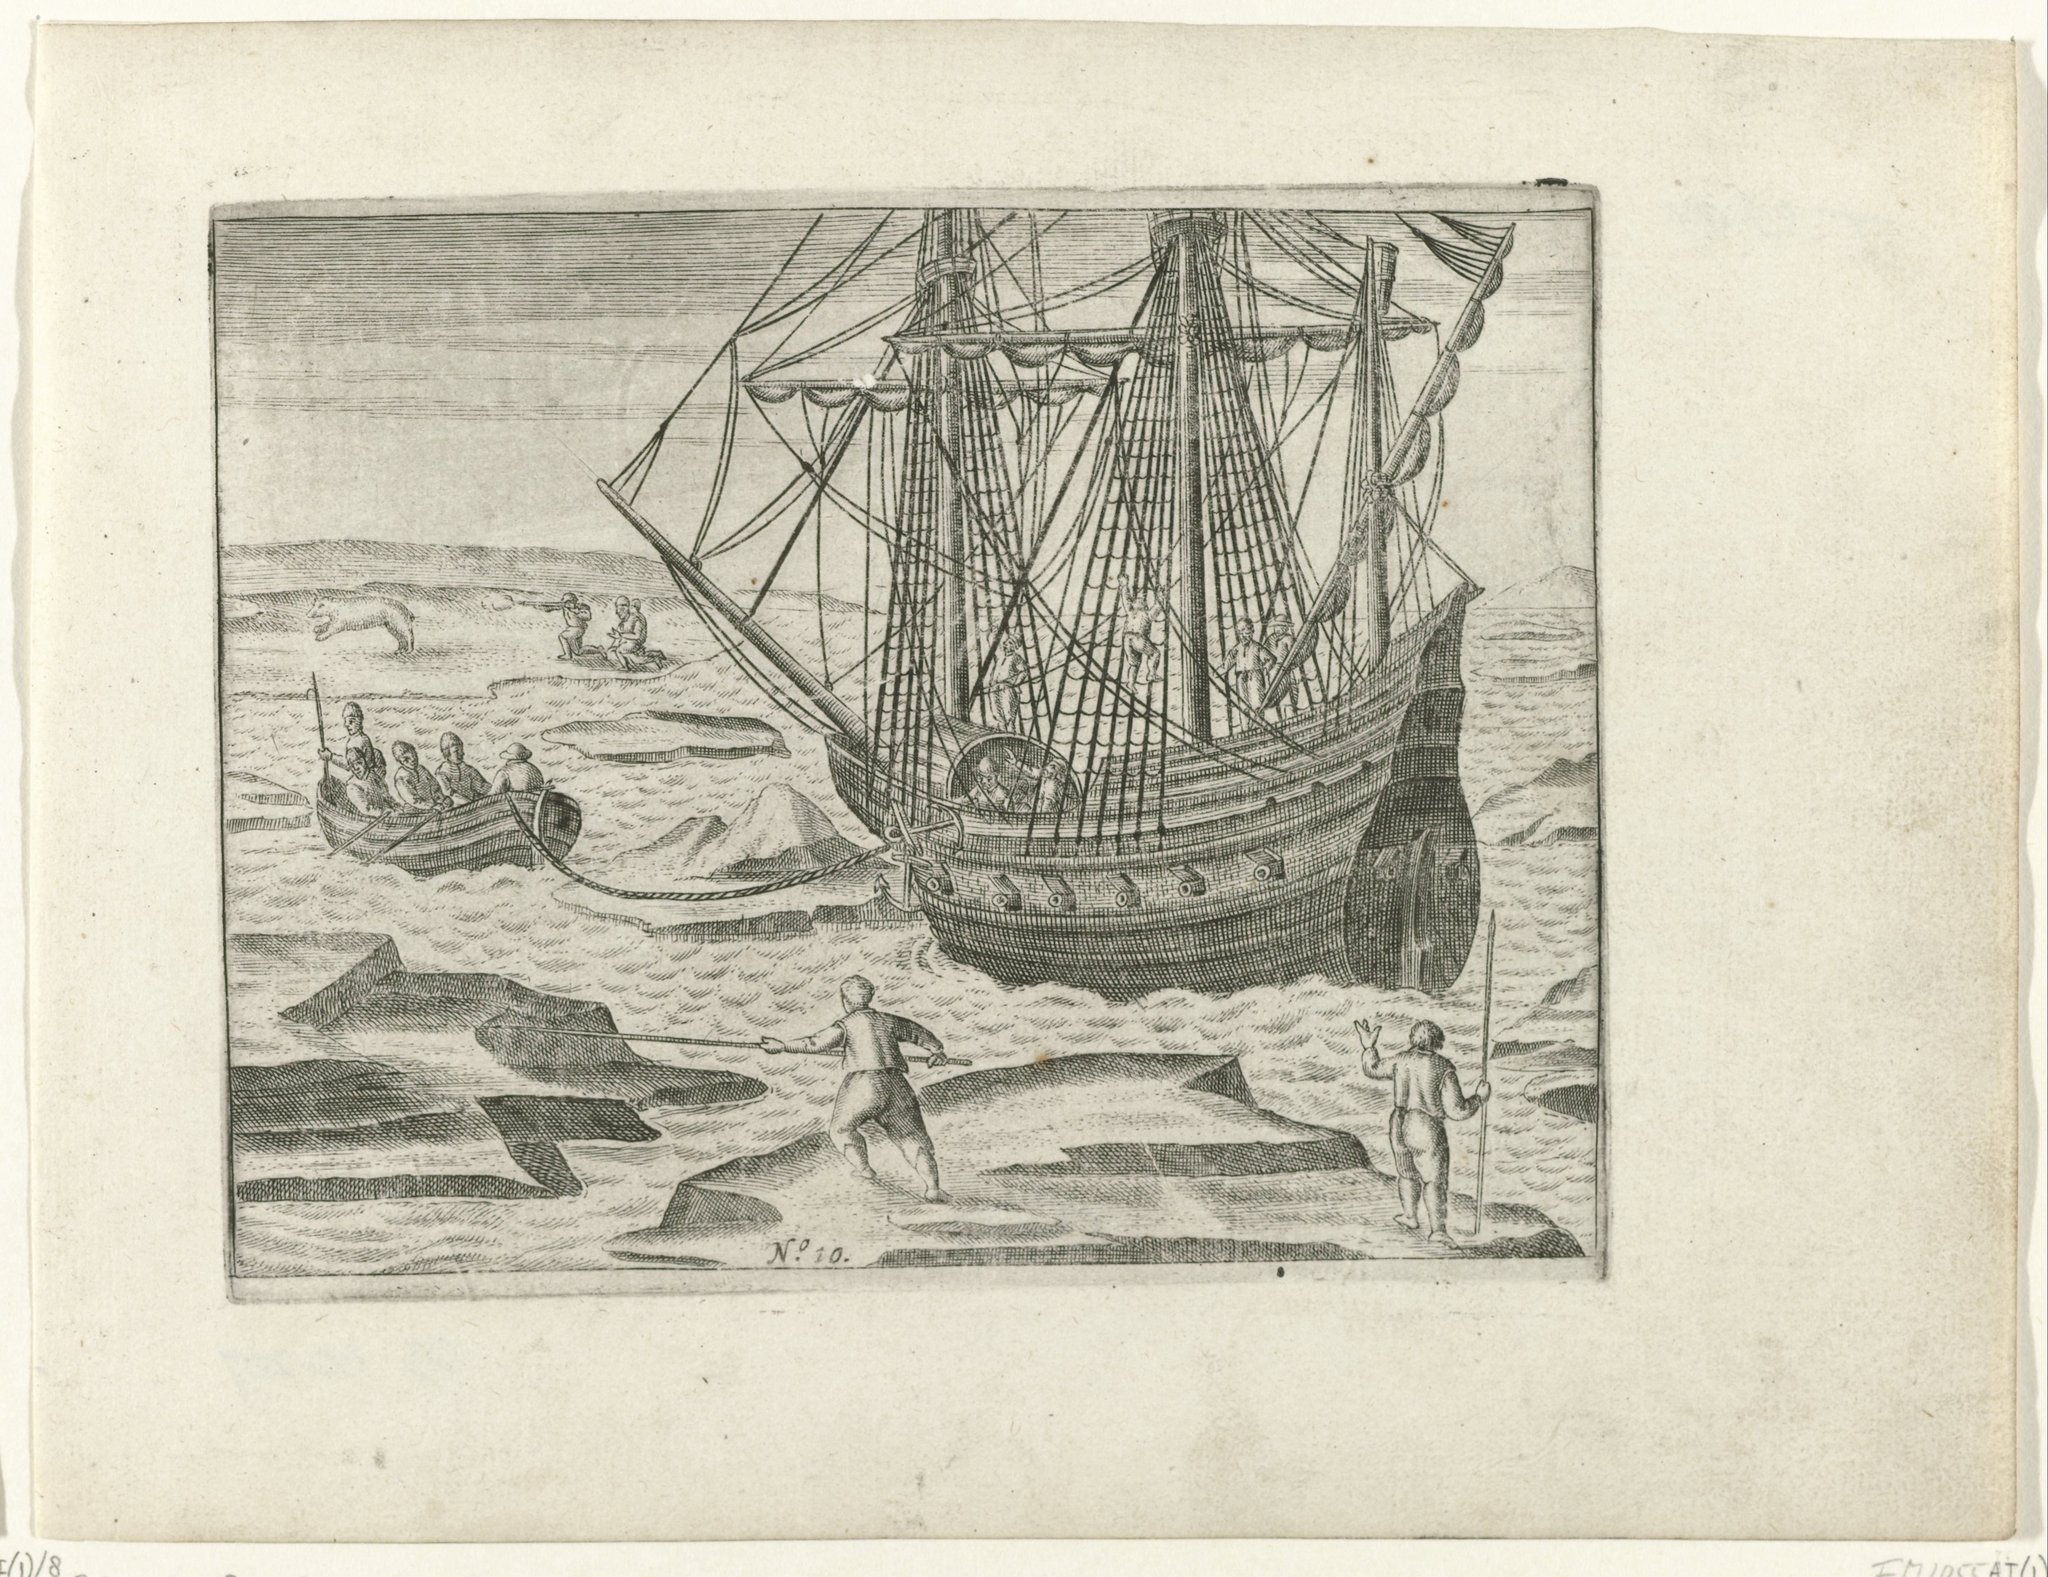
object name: history print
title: Het schip dreigt bij Oranje-eiland in het ijs vast te raken, 1596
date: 1615-1617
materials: paper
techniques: engraving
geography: northern netherlands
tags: willem barendsz., jacob van heemskerck, landscapes in polar regions, exploration, expedition, voyage of discovery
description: Gebruikt als illustratie eerst in: G. de Veer, De waerachtige beschrijvinge vande drie seylagien, drie jaren achter mal-kanderen deur de Hollandtsche ende Zeelandtsche Schepen, by noorden Noorweghen, Moscovien ende tartarien nae de Coninckrijcken van Catthay ende China ghedaene, [Michiel Colijn, Amsterdam 1617]. Later gebruikt in: Kort verhael van d'eerste Schipvaerd der Hollandsche ende Zeeusche Schepen by noorden Noorwegen, Moscovien ende Tartarien om, nae de Coningrijcken van Cathay ende China, getogen uyt het Journael van Gerrit de Veer. Opgenomen in: I. Commelin, Begin ende voortgangh, van de Vereenighde Nederlantsche Geoctroyeerde Oost-Indische Compagnie, J. Janssonius, Amsterdam 1646. Genummerd: No. 10.